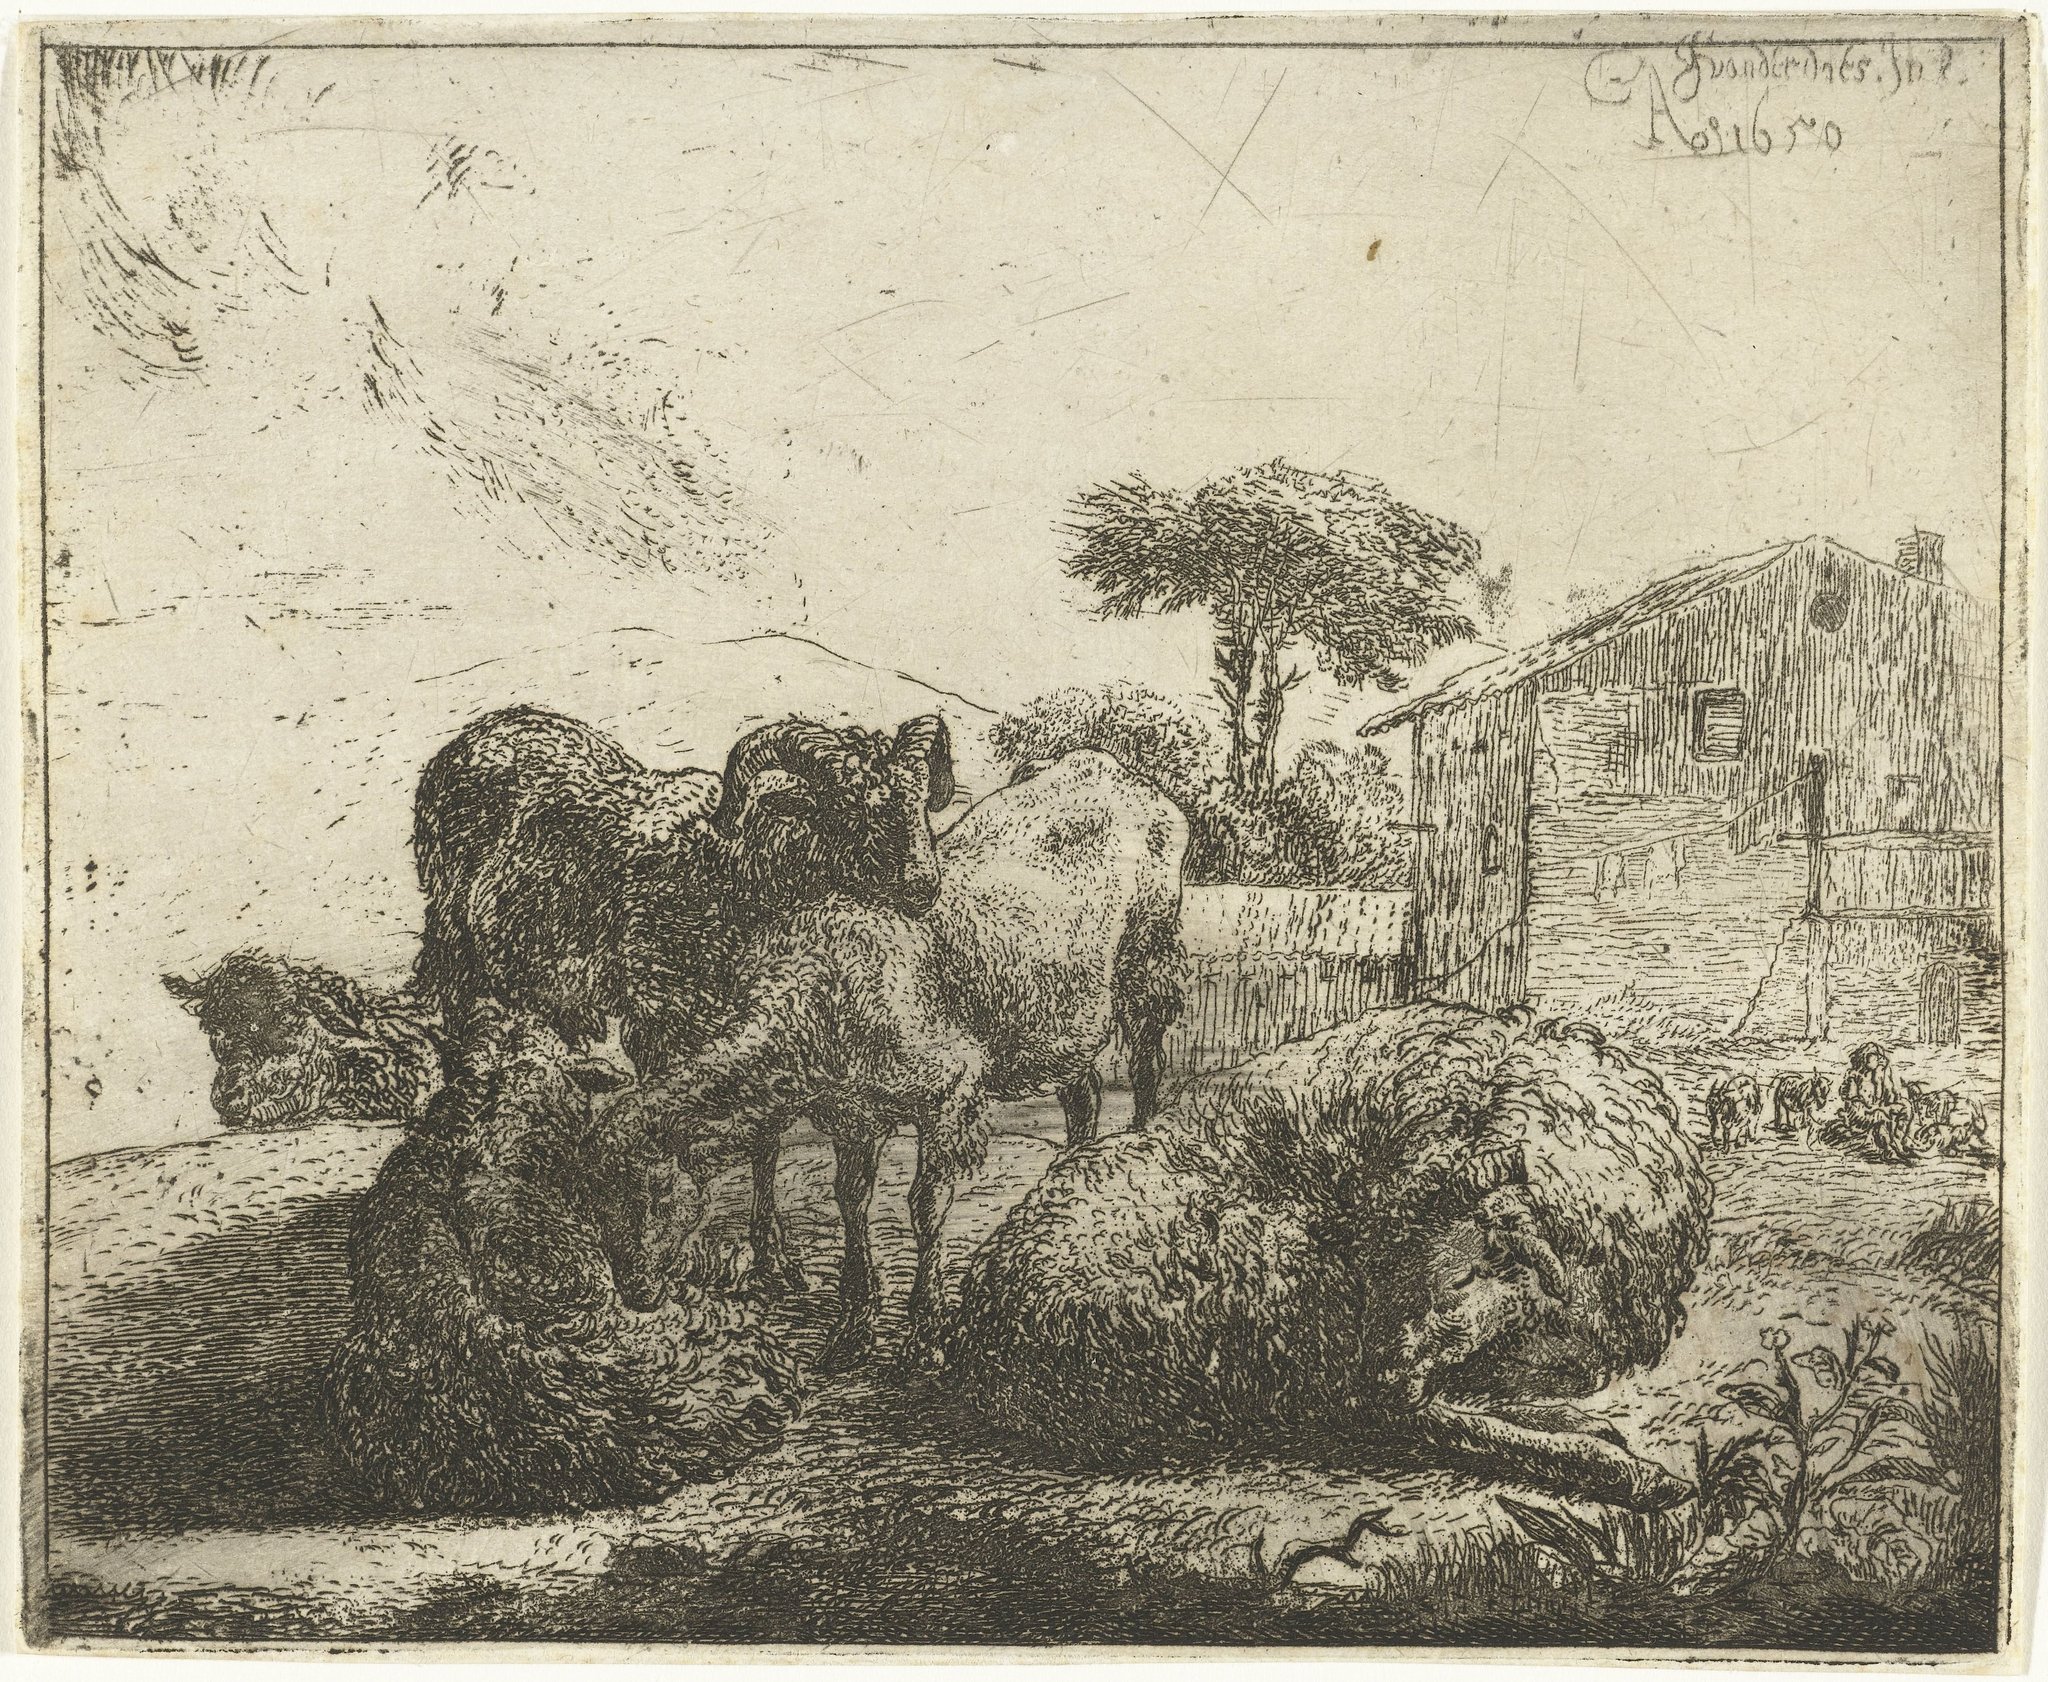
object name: print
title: Groep van vijf schapen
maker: jacob van der does (i)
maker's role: draughtsman, painter, print maker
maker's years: 1623-1673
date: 1650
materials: paper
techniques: etching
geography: netherlands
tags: sheep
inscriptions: collector's mark: Lugt 240